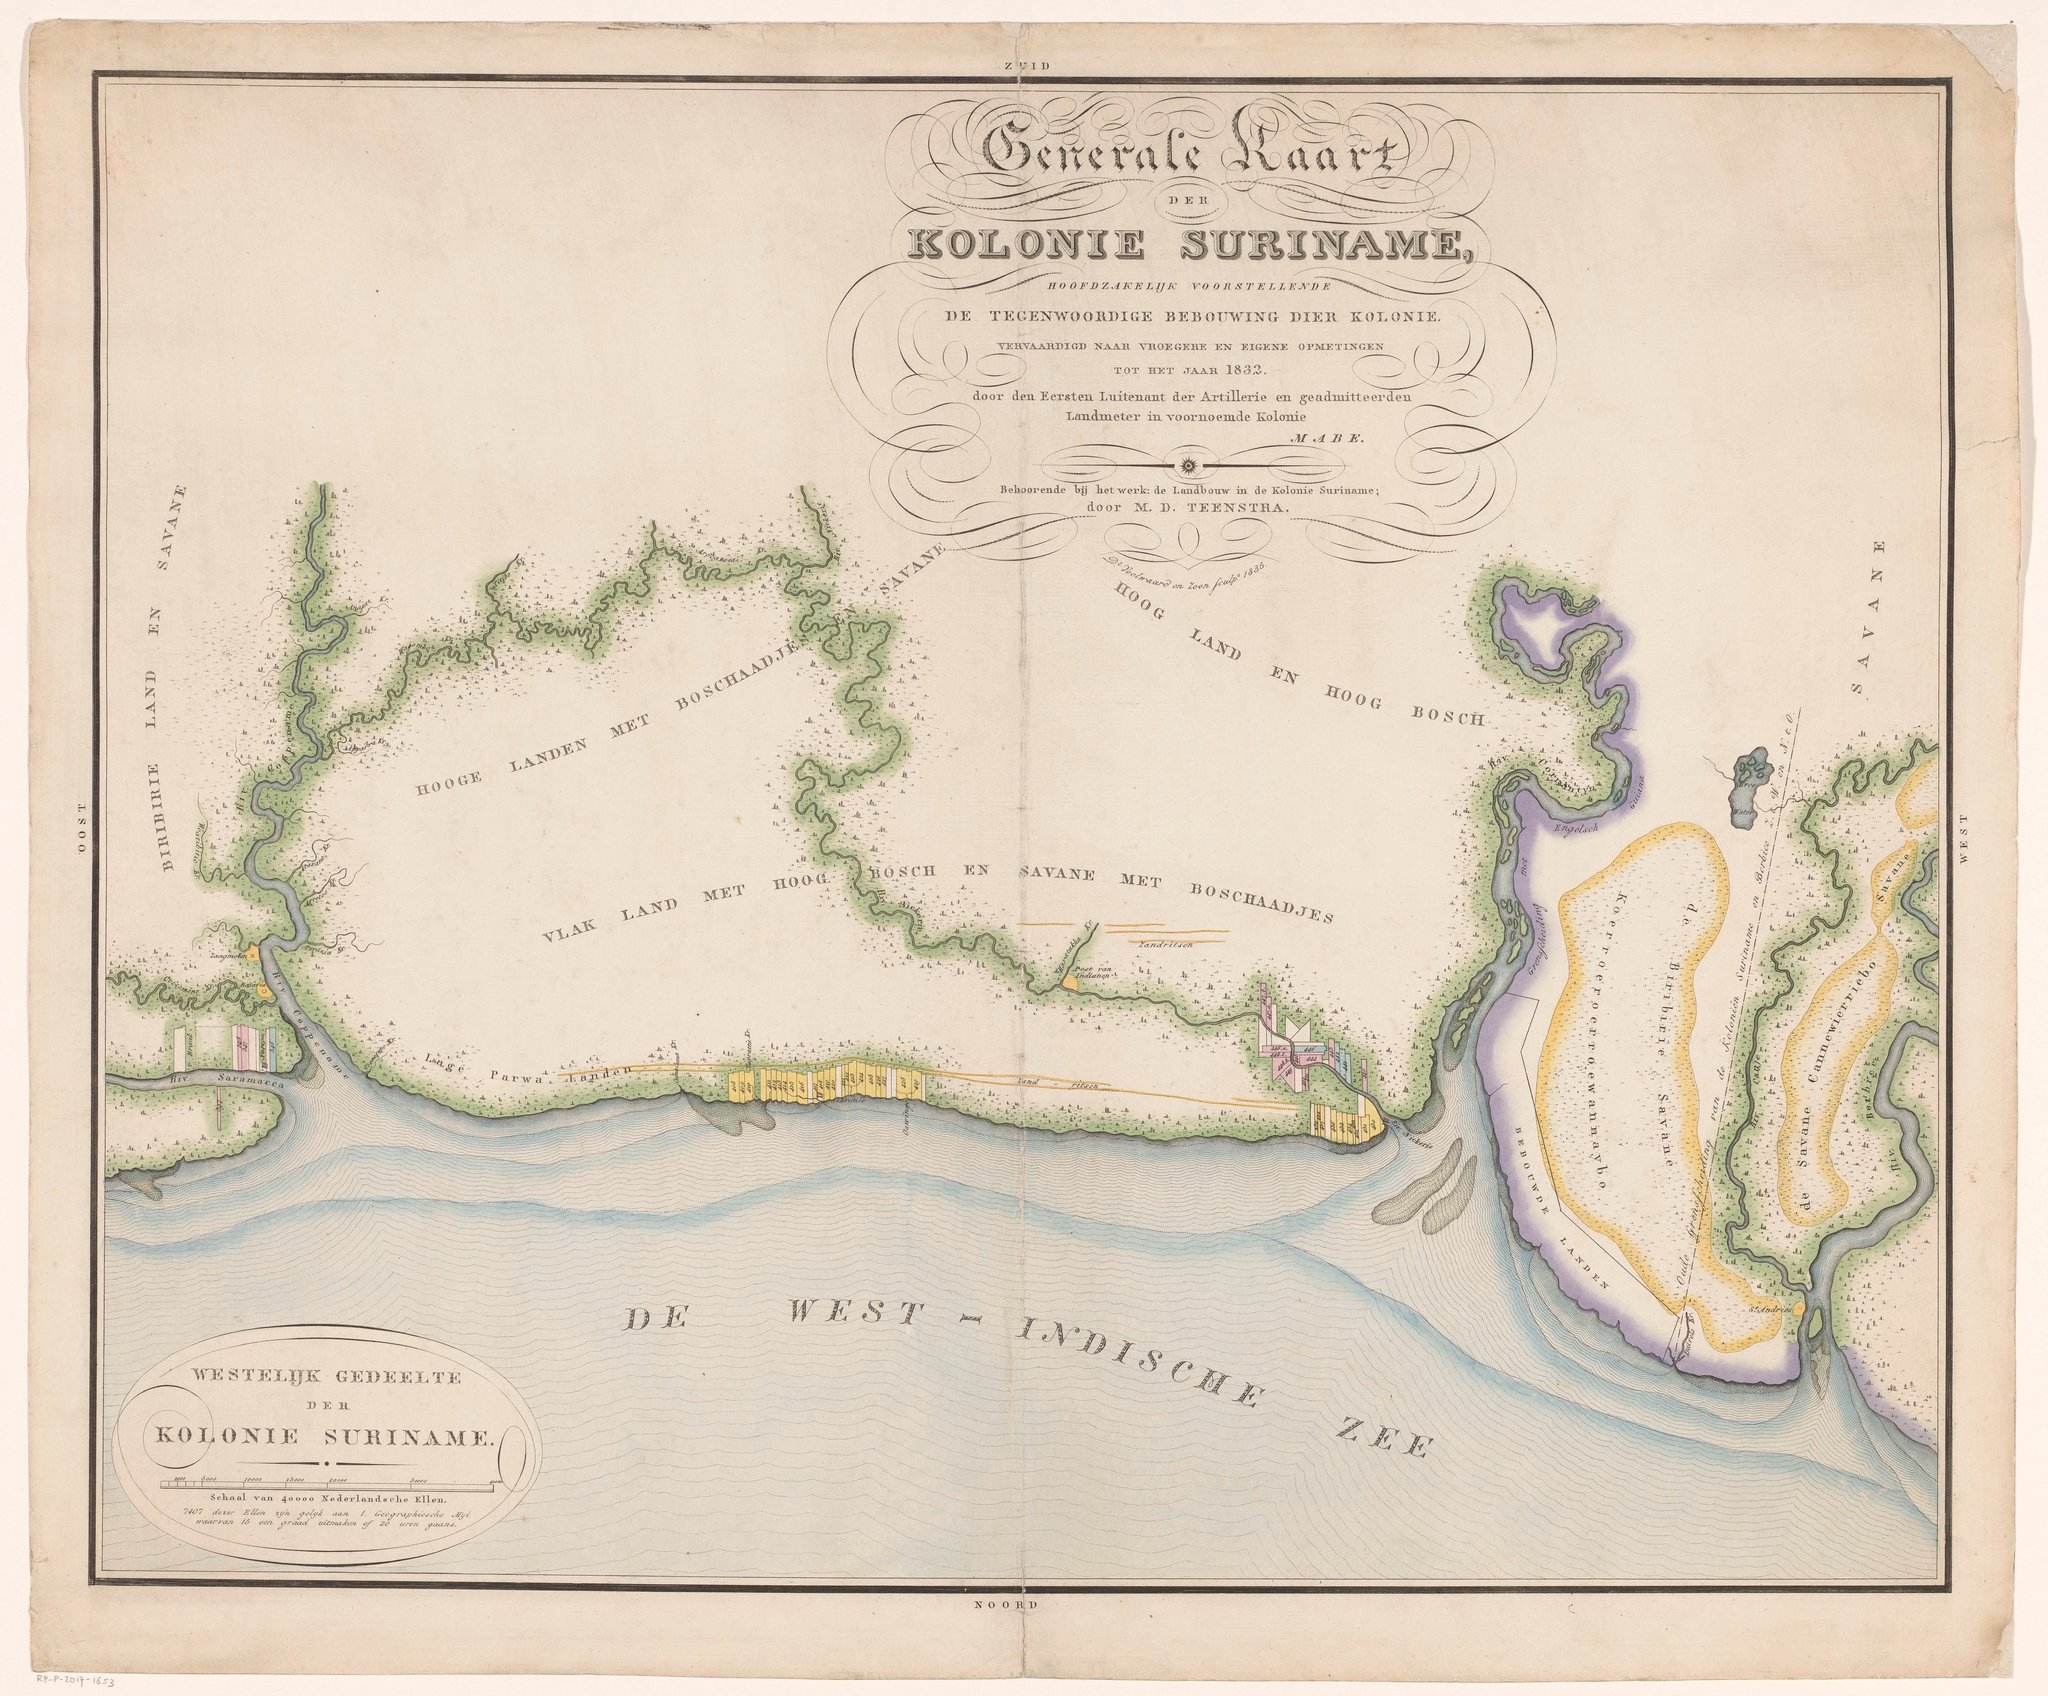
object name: print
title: Generale kaart der kolonie Suriname, hoofdzakelijk voorstellende de tegenwoordige bebouwing dier kolonie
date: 1835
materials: paper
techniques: engraving, etching, hand coloring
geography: amsterdam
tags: maps of separate countries or regions, ocean, suriname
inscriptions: date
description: Prent maakt deel uit van een kaart van Suriname behorende bij de publicatie: Teenstra, M.D. De landbouw in de kolonie Suriname. Groningen: H. Eekhoff Hzn, 1835.